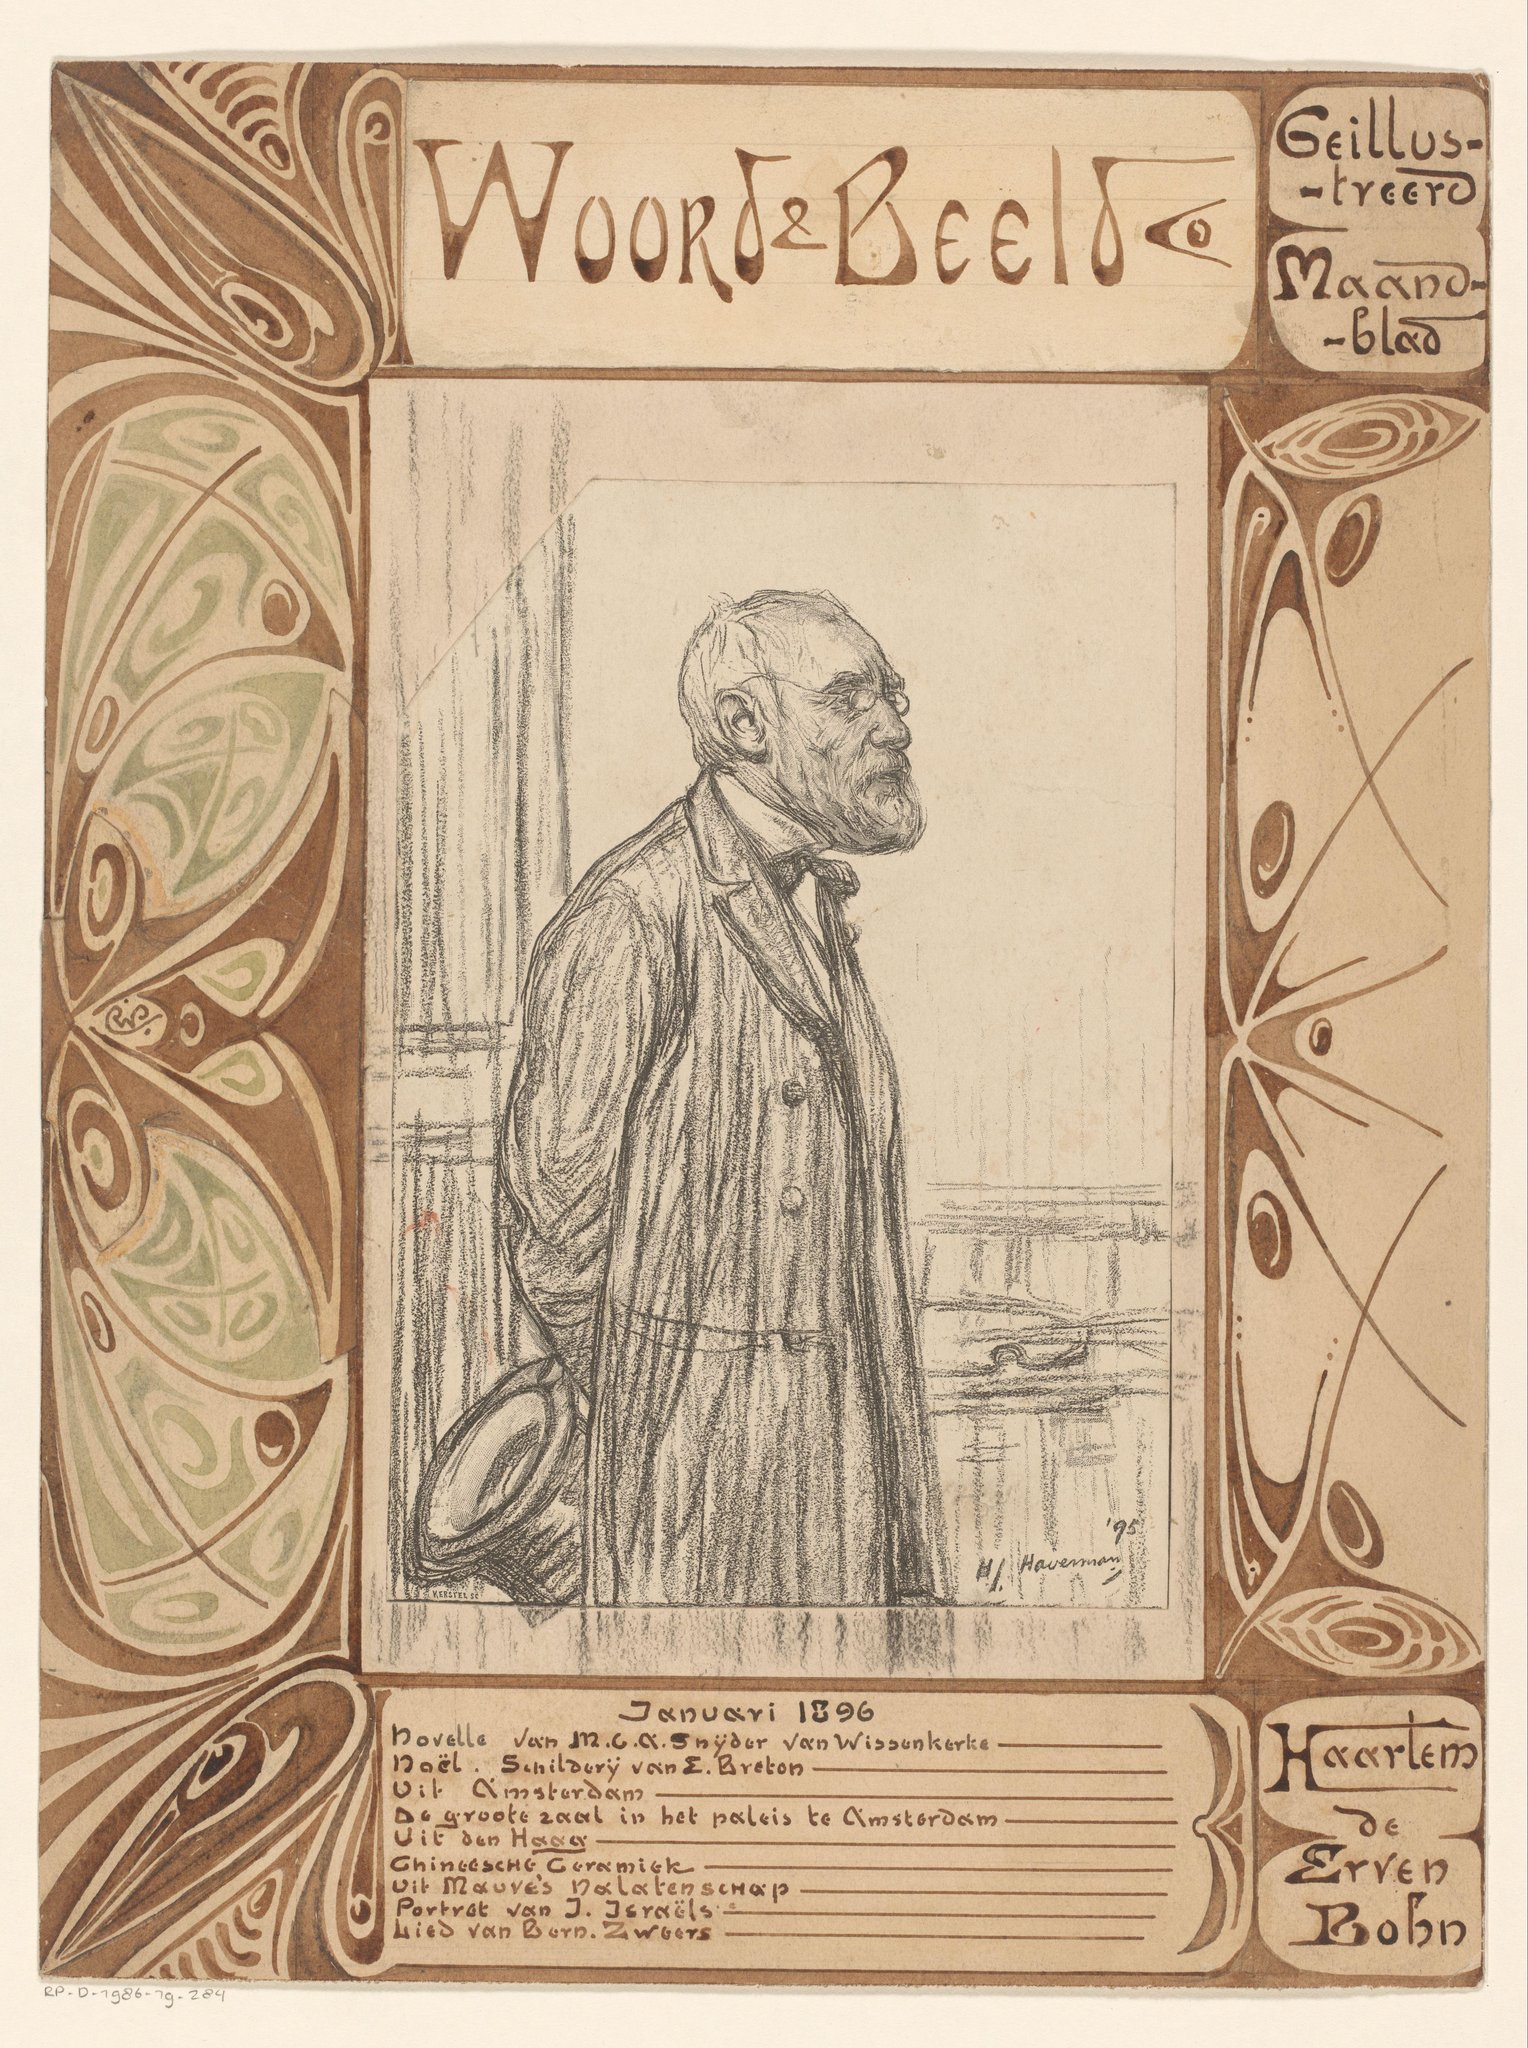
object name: design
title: Omslagontwerp voor: Woord en Beeld. Geïllustreerd Maandblad, 1896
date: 1895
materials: chalk, ink, paper, pencil, watercolor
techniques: brush, engraving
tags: the hague, painter, print maker, draughtsman, jozef israëls, ornaments ~ art, portrait, self-portrait of artist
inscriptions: collector's mark: ‘R:MVS.’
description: Omslagontwerp met een portret van Jozef Israëls die een hoed vasthoudt. Het portret is omsloten door een geornamenteerd kader met onderaan een inhoudsopgave.